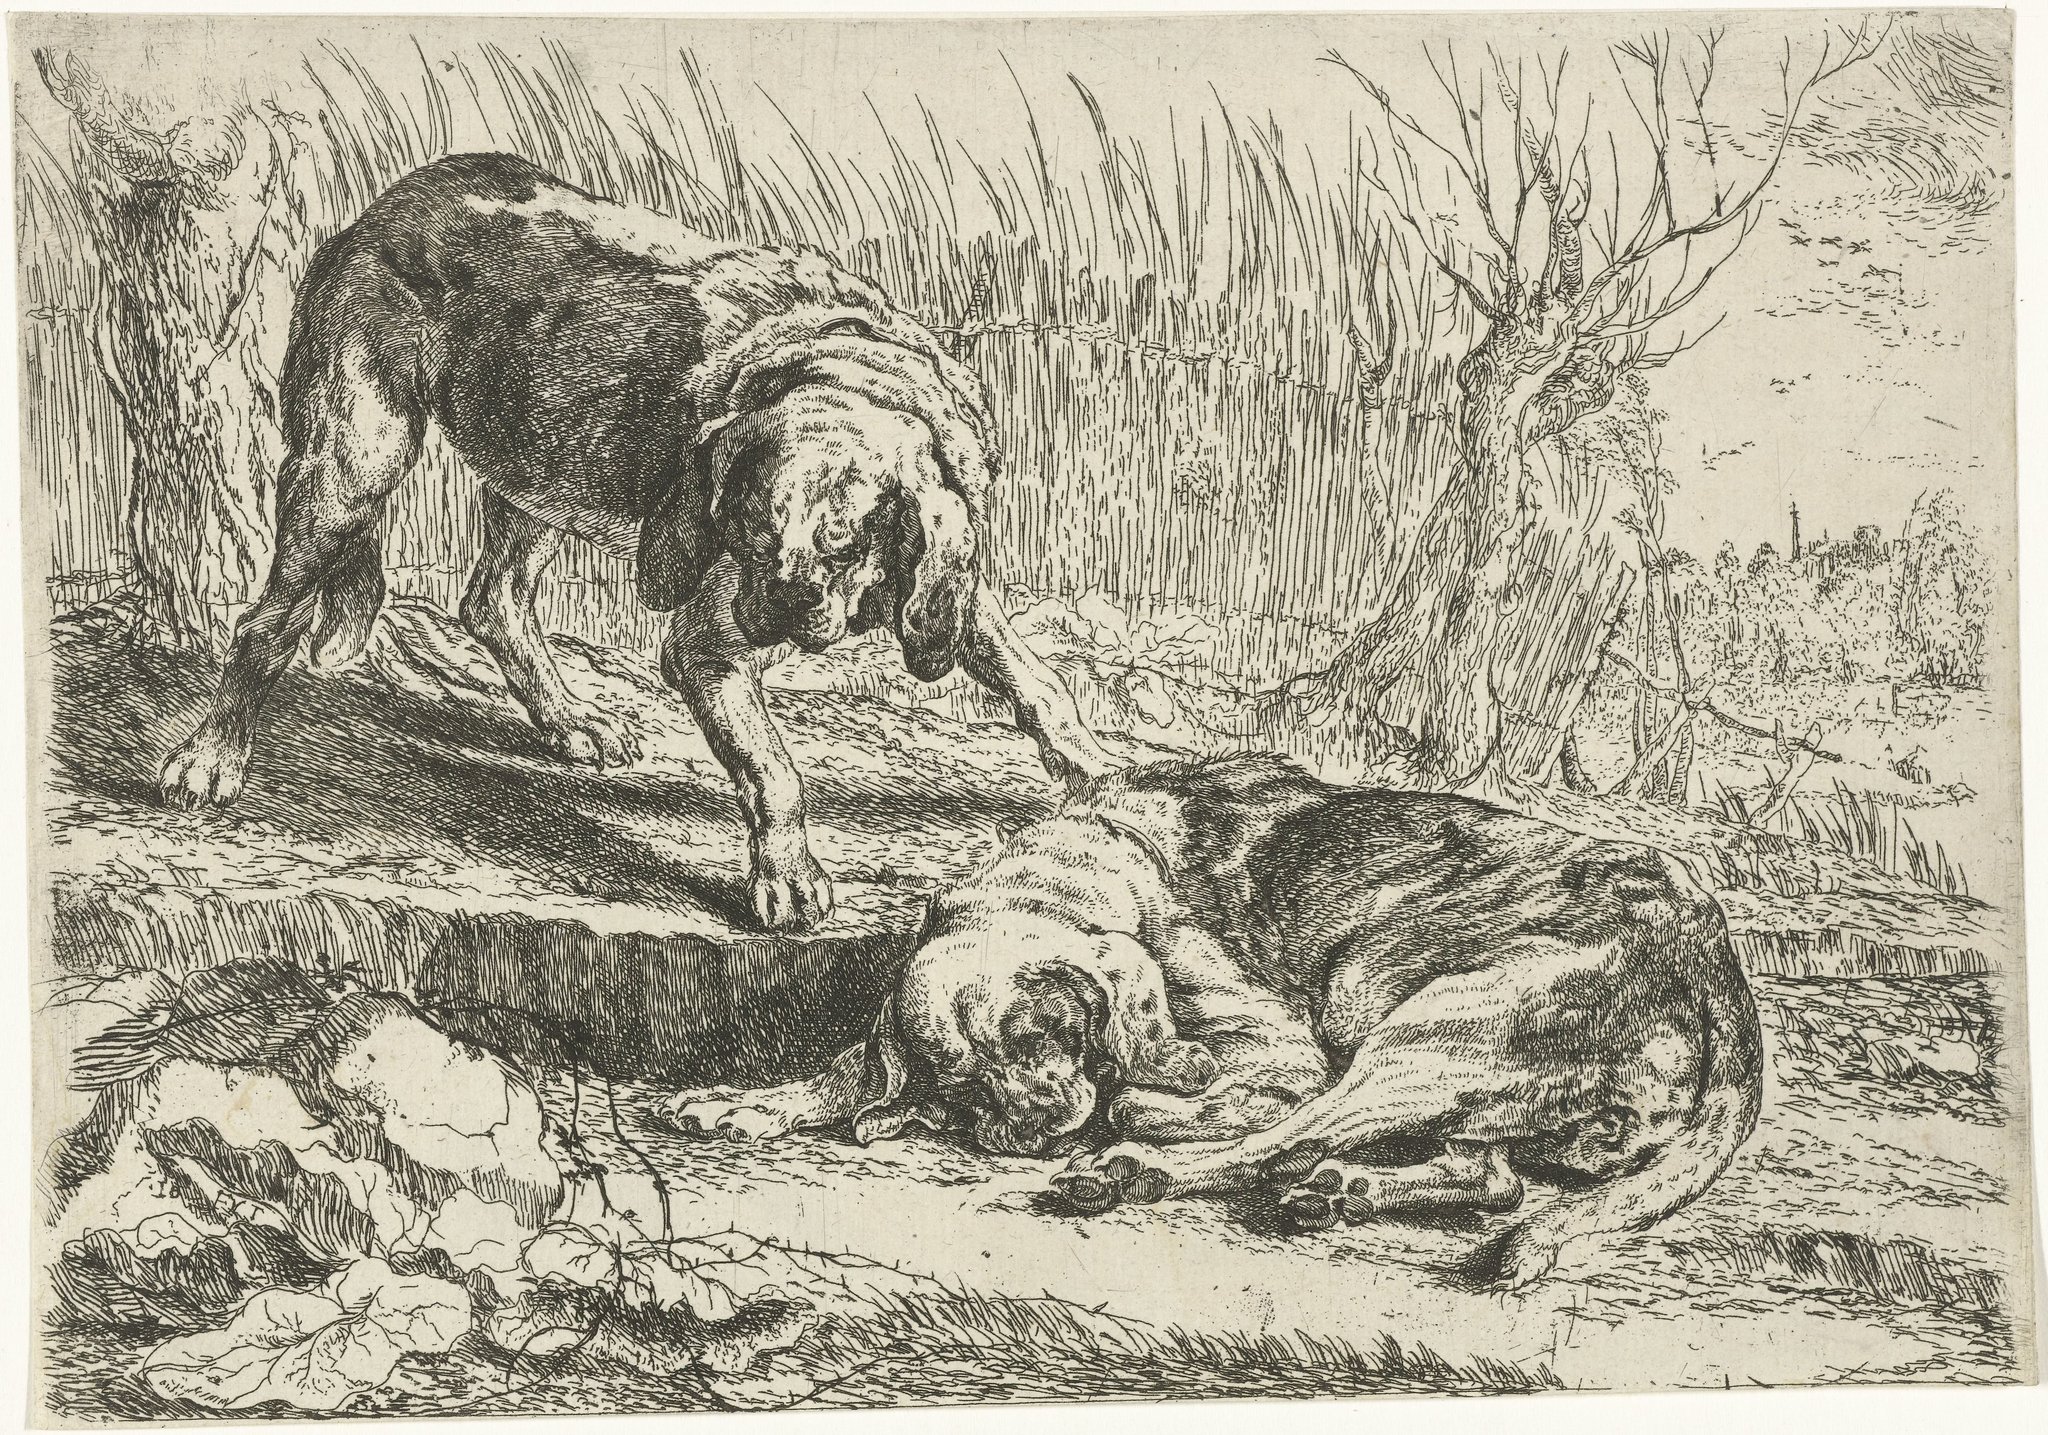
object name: print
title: Twee honden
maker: joannes fijt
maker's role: draughtsman, print maker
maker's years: 1611-1661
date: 1642-1667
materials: paper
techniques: etching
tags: dog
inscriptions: collector's mark: Lugt 240